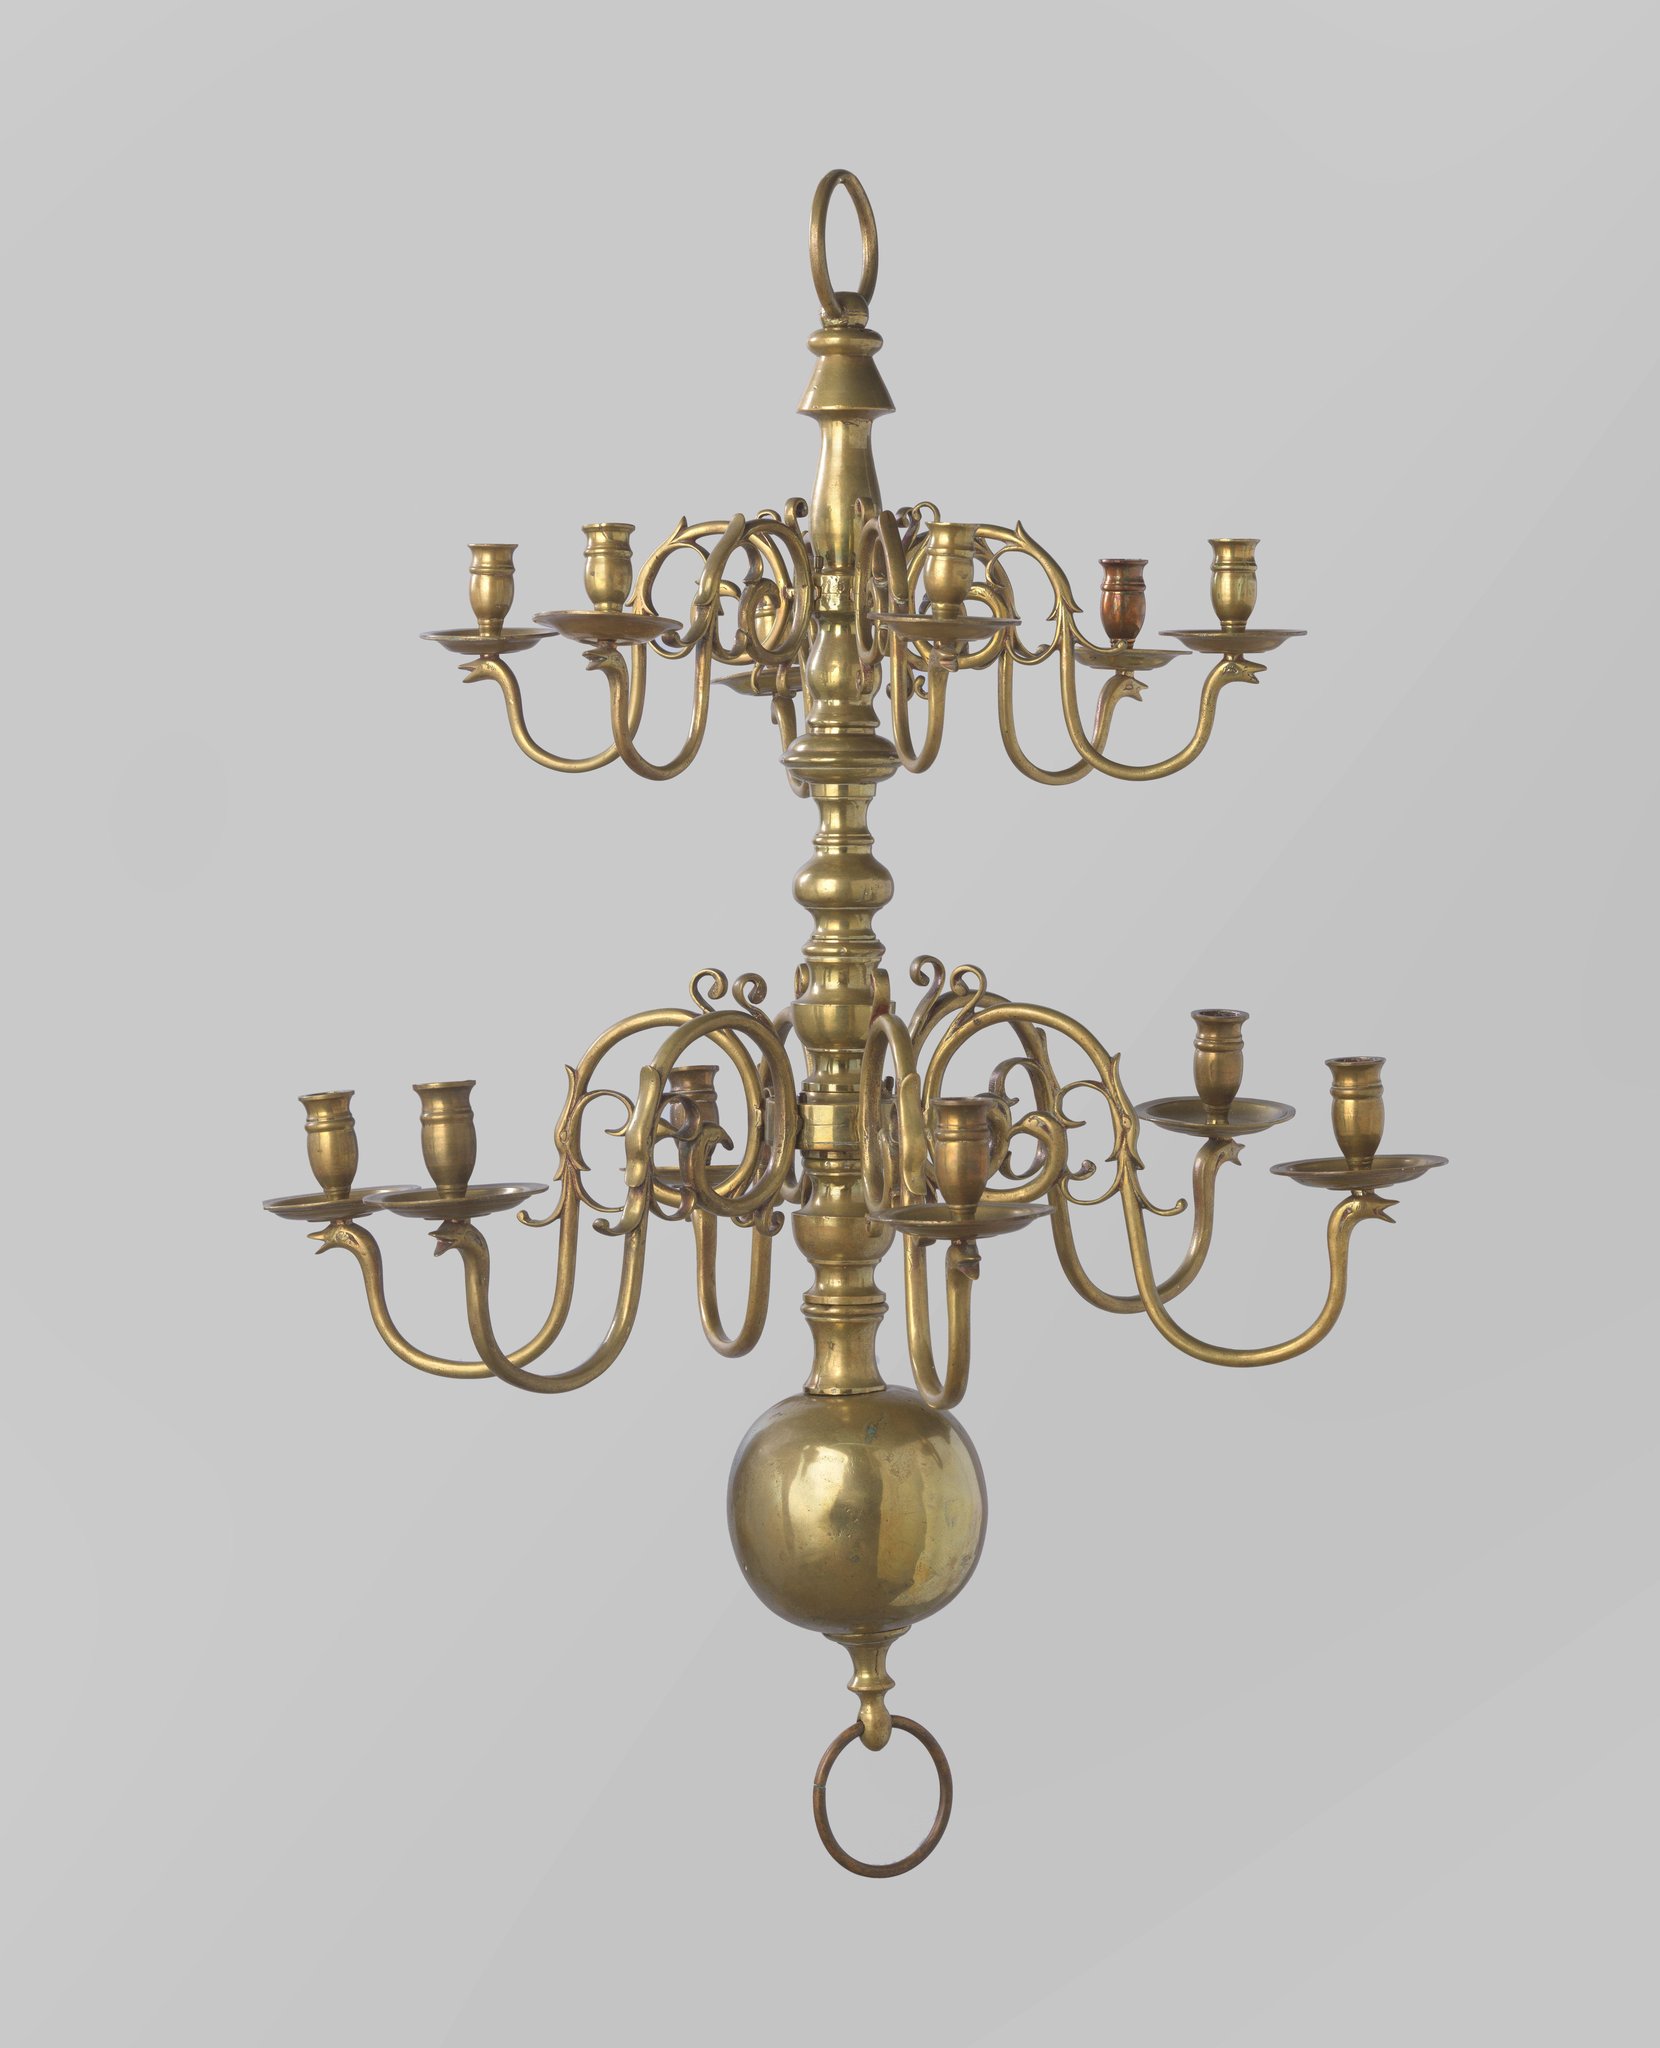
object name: chandelier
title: Arm van een kaarsenkroon in twee hoogten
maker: Anonymous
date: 1890-1910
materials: brass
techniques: casting, screwed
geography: netherlands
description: De arm heeft een S-vorm, naar buiten toe eindigend in een slangenkop en op het andere eind in vogelkop. De arm is aldaar met krullen versierd. Er is schroefdraden aangebracht in het uitsteeksel aan de kaarsenhouder, de arm of op het einde van de verbindingsstang. In het midden heeft de arm tevens een gestileerde dierenkop. Dit is de tweede arm van de onderste standring, genummerd met het cijfer 2.